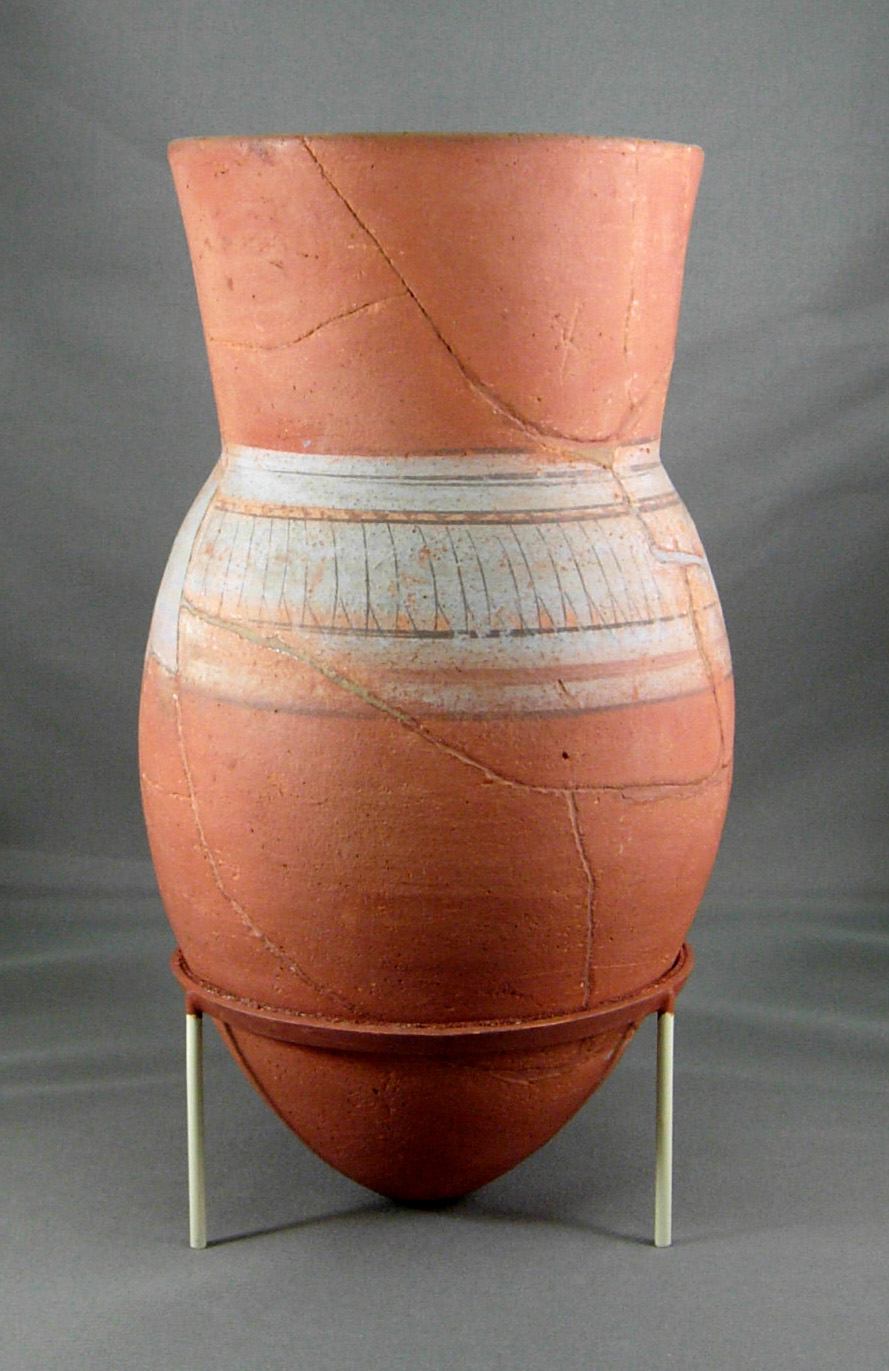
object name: jar, painted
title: Painted Jar from Tutankhamun's Embalming Cache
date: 1336-1327 BCE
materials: pigment, pottery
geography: egypt